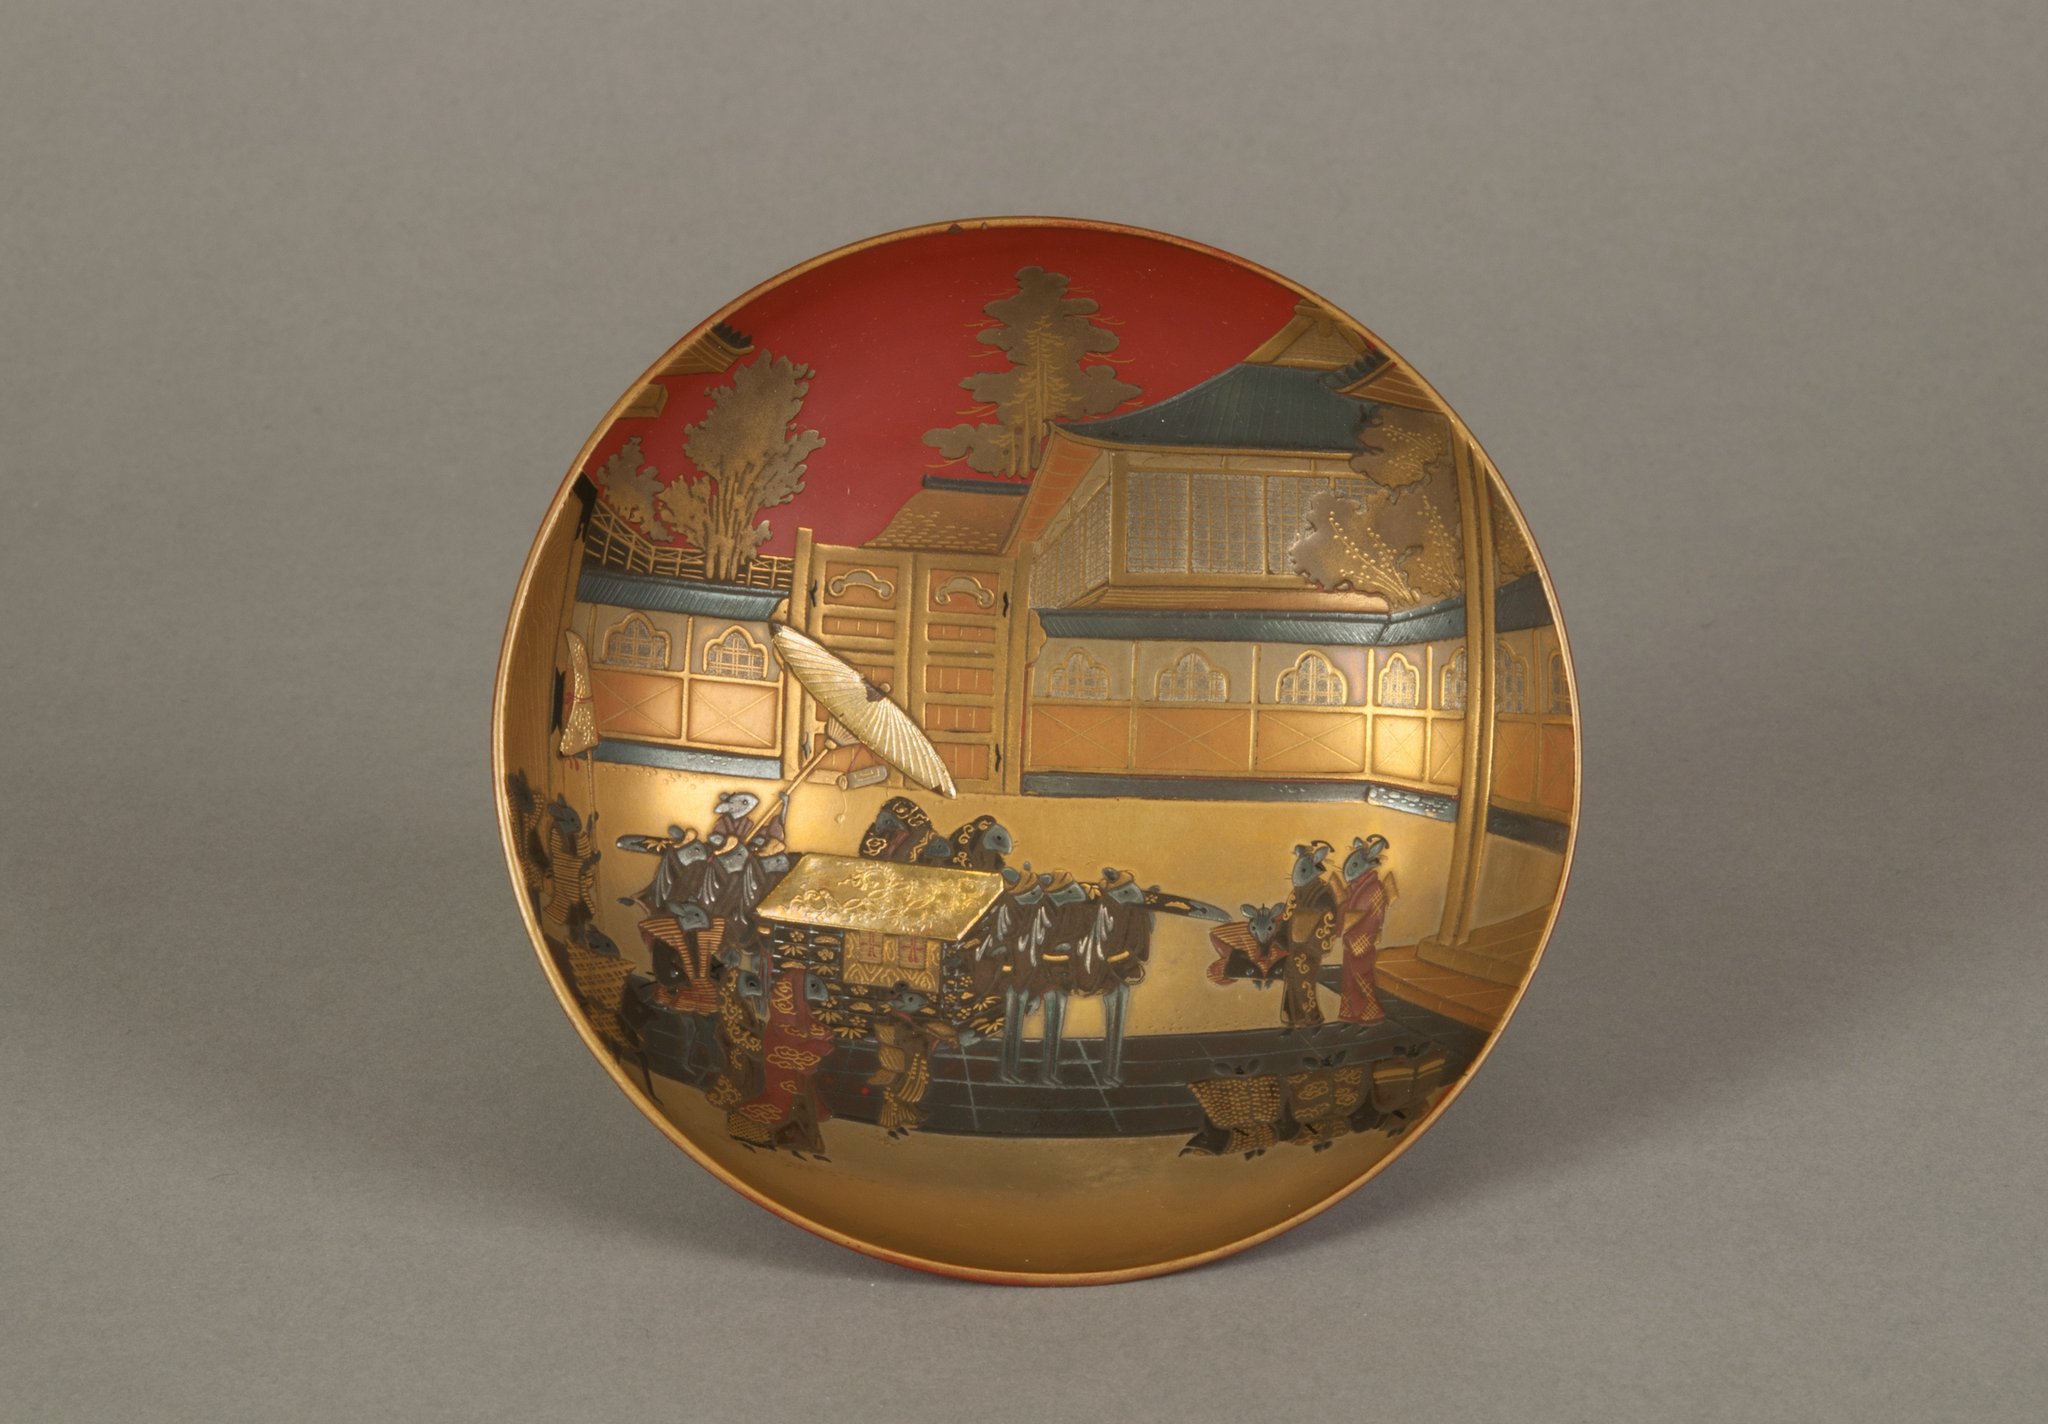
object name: wine cup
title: One of a Pair of Wine Cups (Sakazuki) with Mice’s Wedding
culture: japanese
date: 1801-1900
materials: gold, gold foil, lacquer, silver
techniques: maki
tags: houses,mice,trees